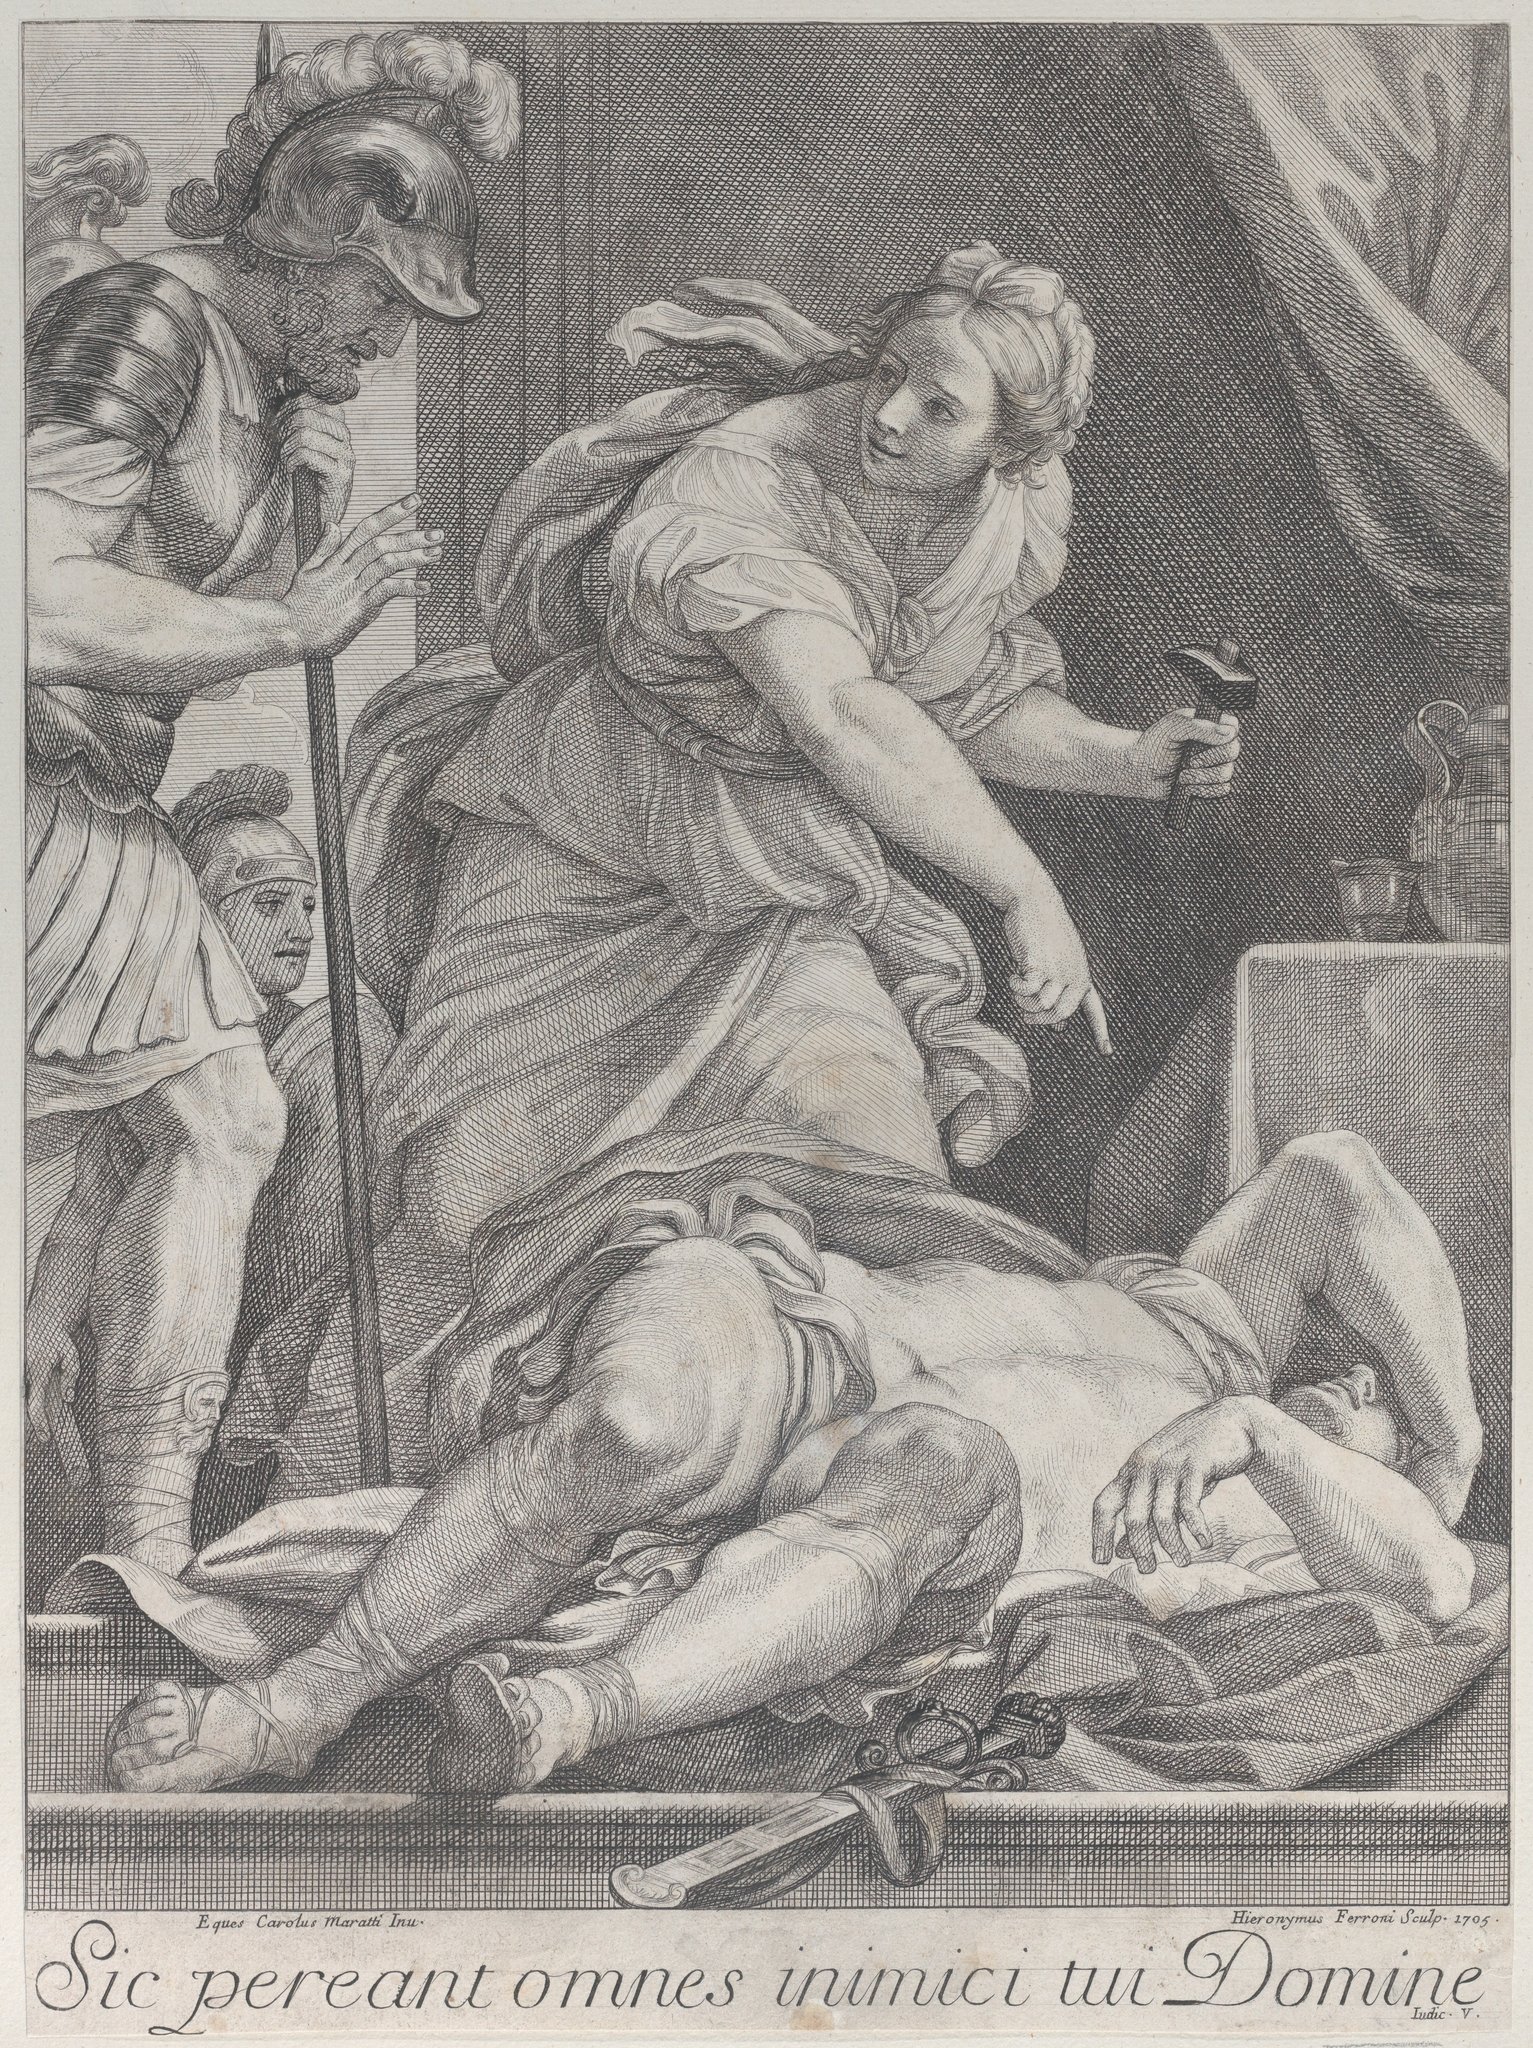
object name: print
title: Jael slaying Sisera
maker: hieronymus ferroni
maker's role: artist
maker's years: 1687-1730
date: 1705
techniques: etching